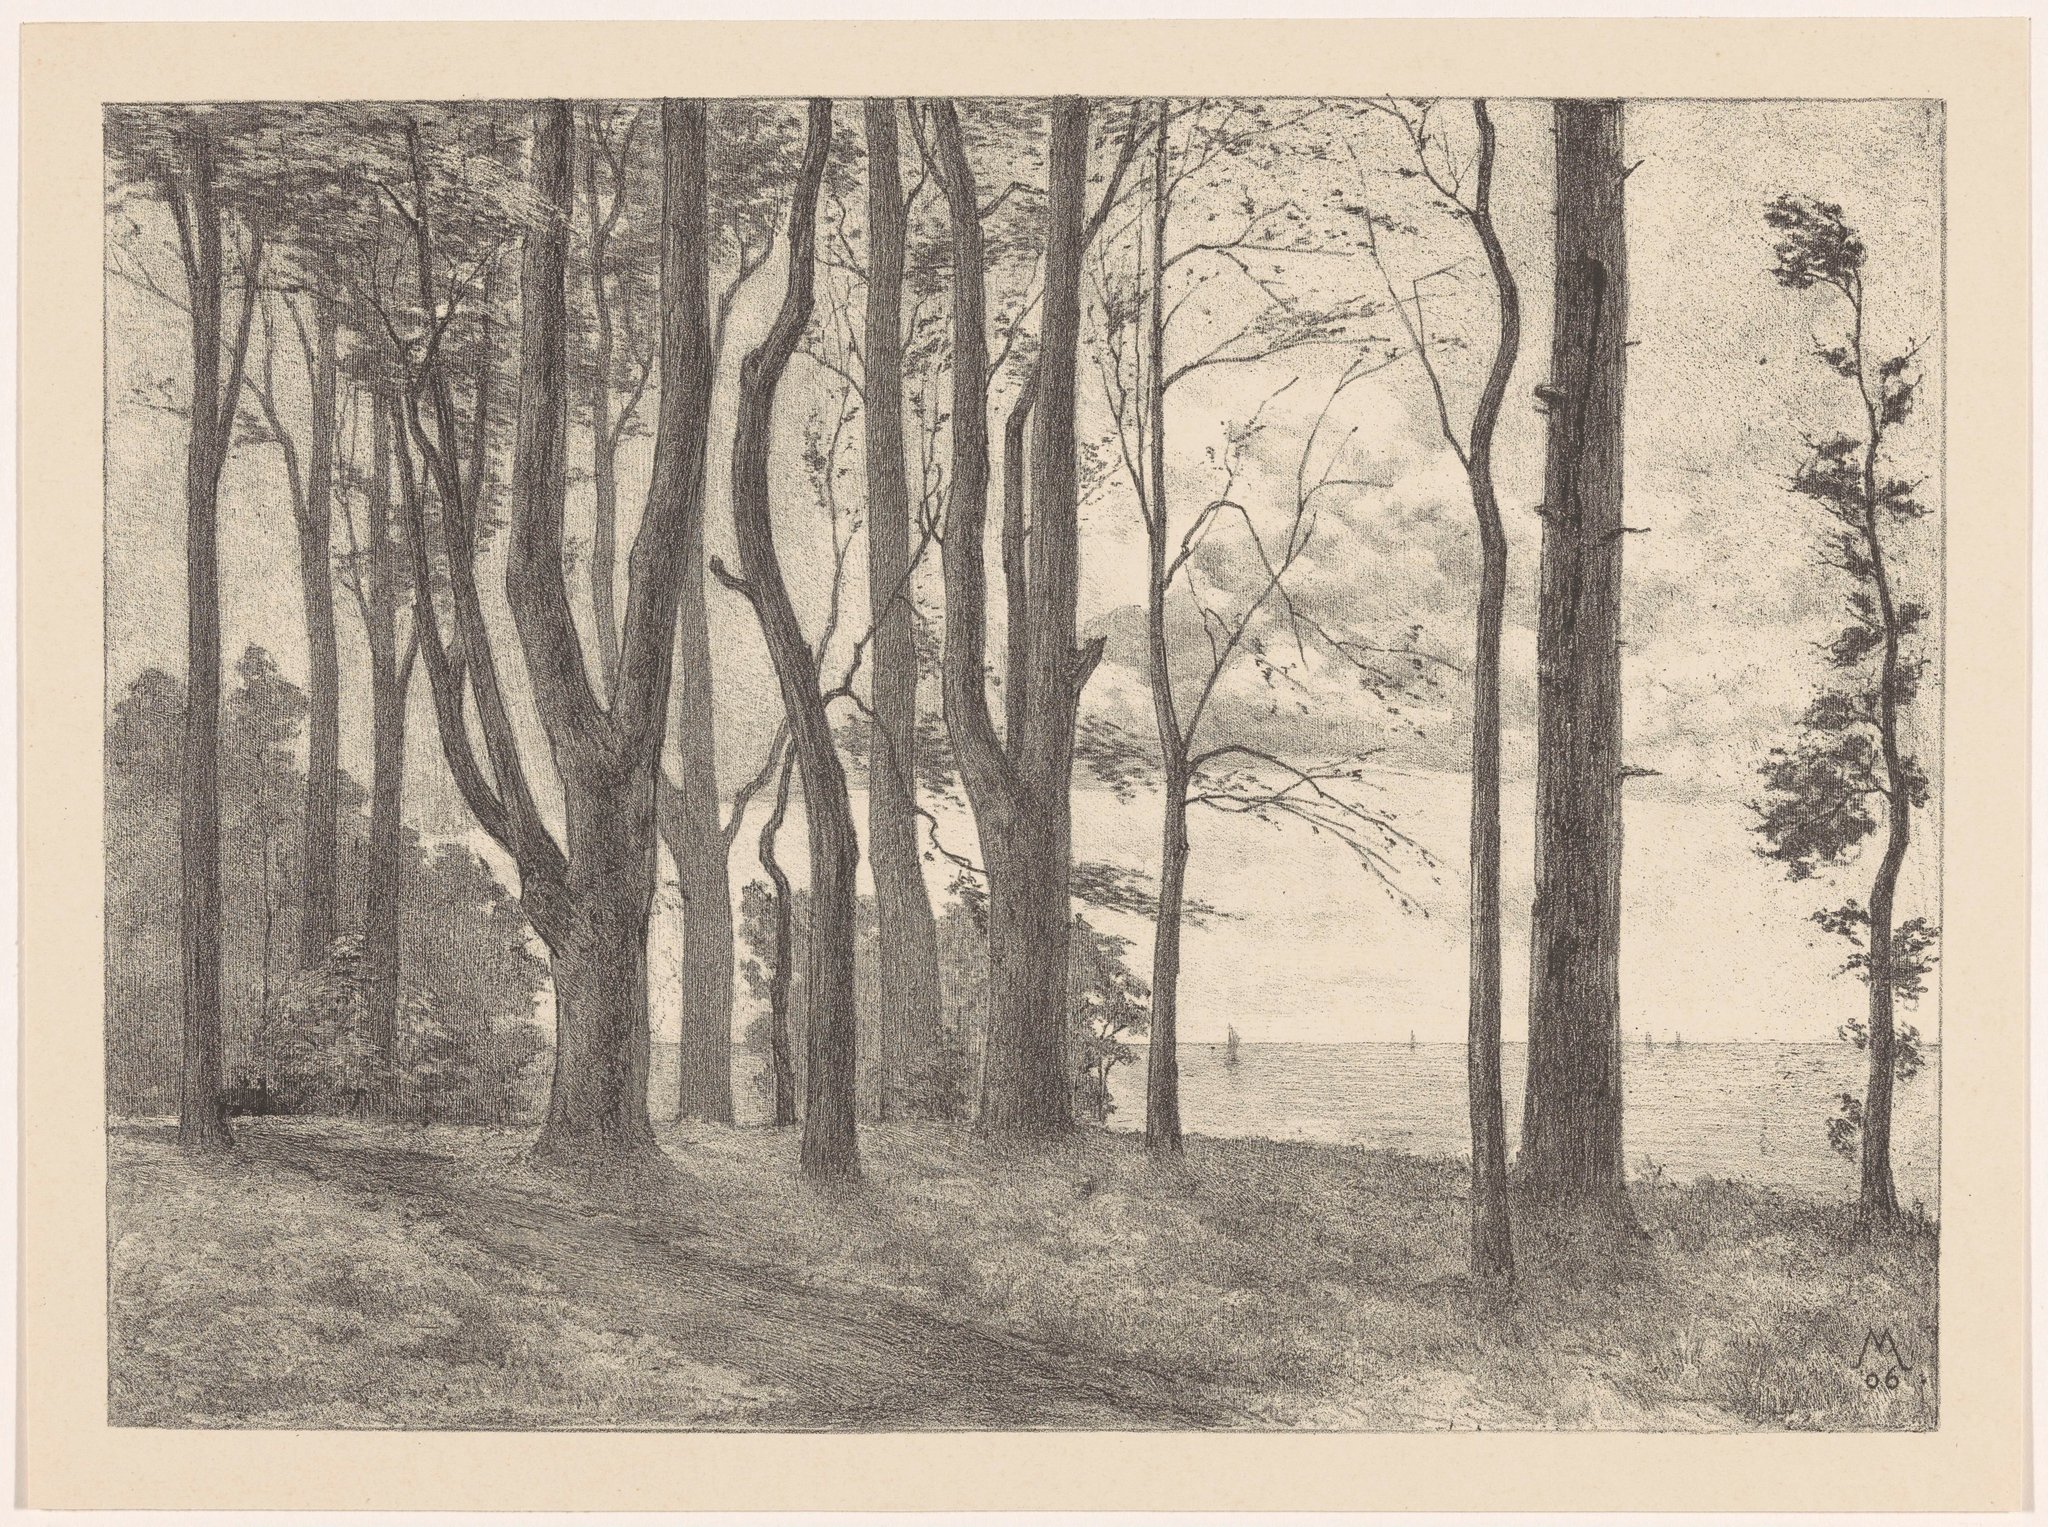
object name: print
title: Bomen aan water met zeilboten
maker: simon moulijn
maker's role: draughtsman, print maker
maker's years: 1866-1948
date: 1906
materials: paper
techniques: lithograph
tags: trees, lake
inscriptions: collector's mark: Lugt 2228